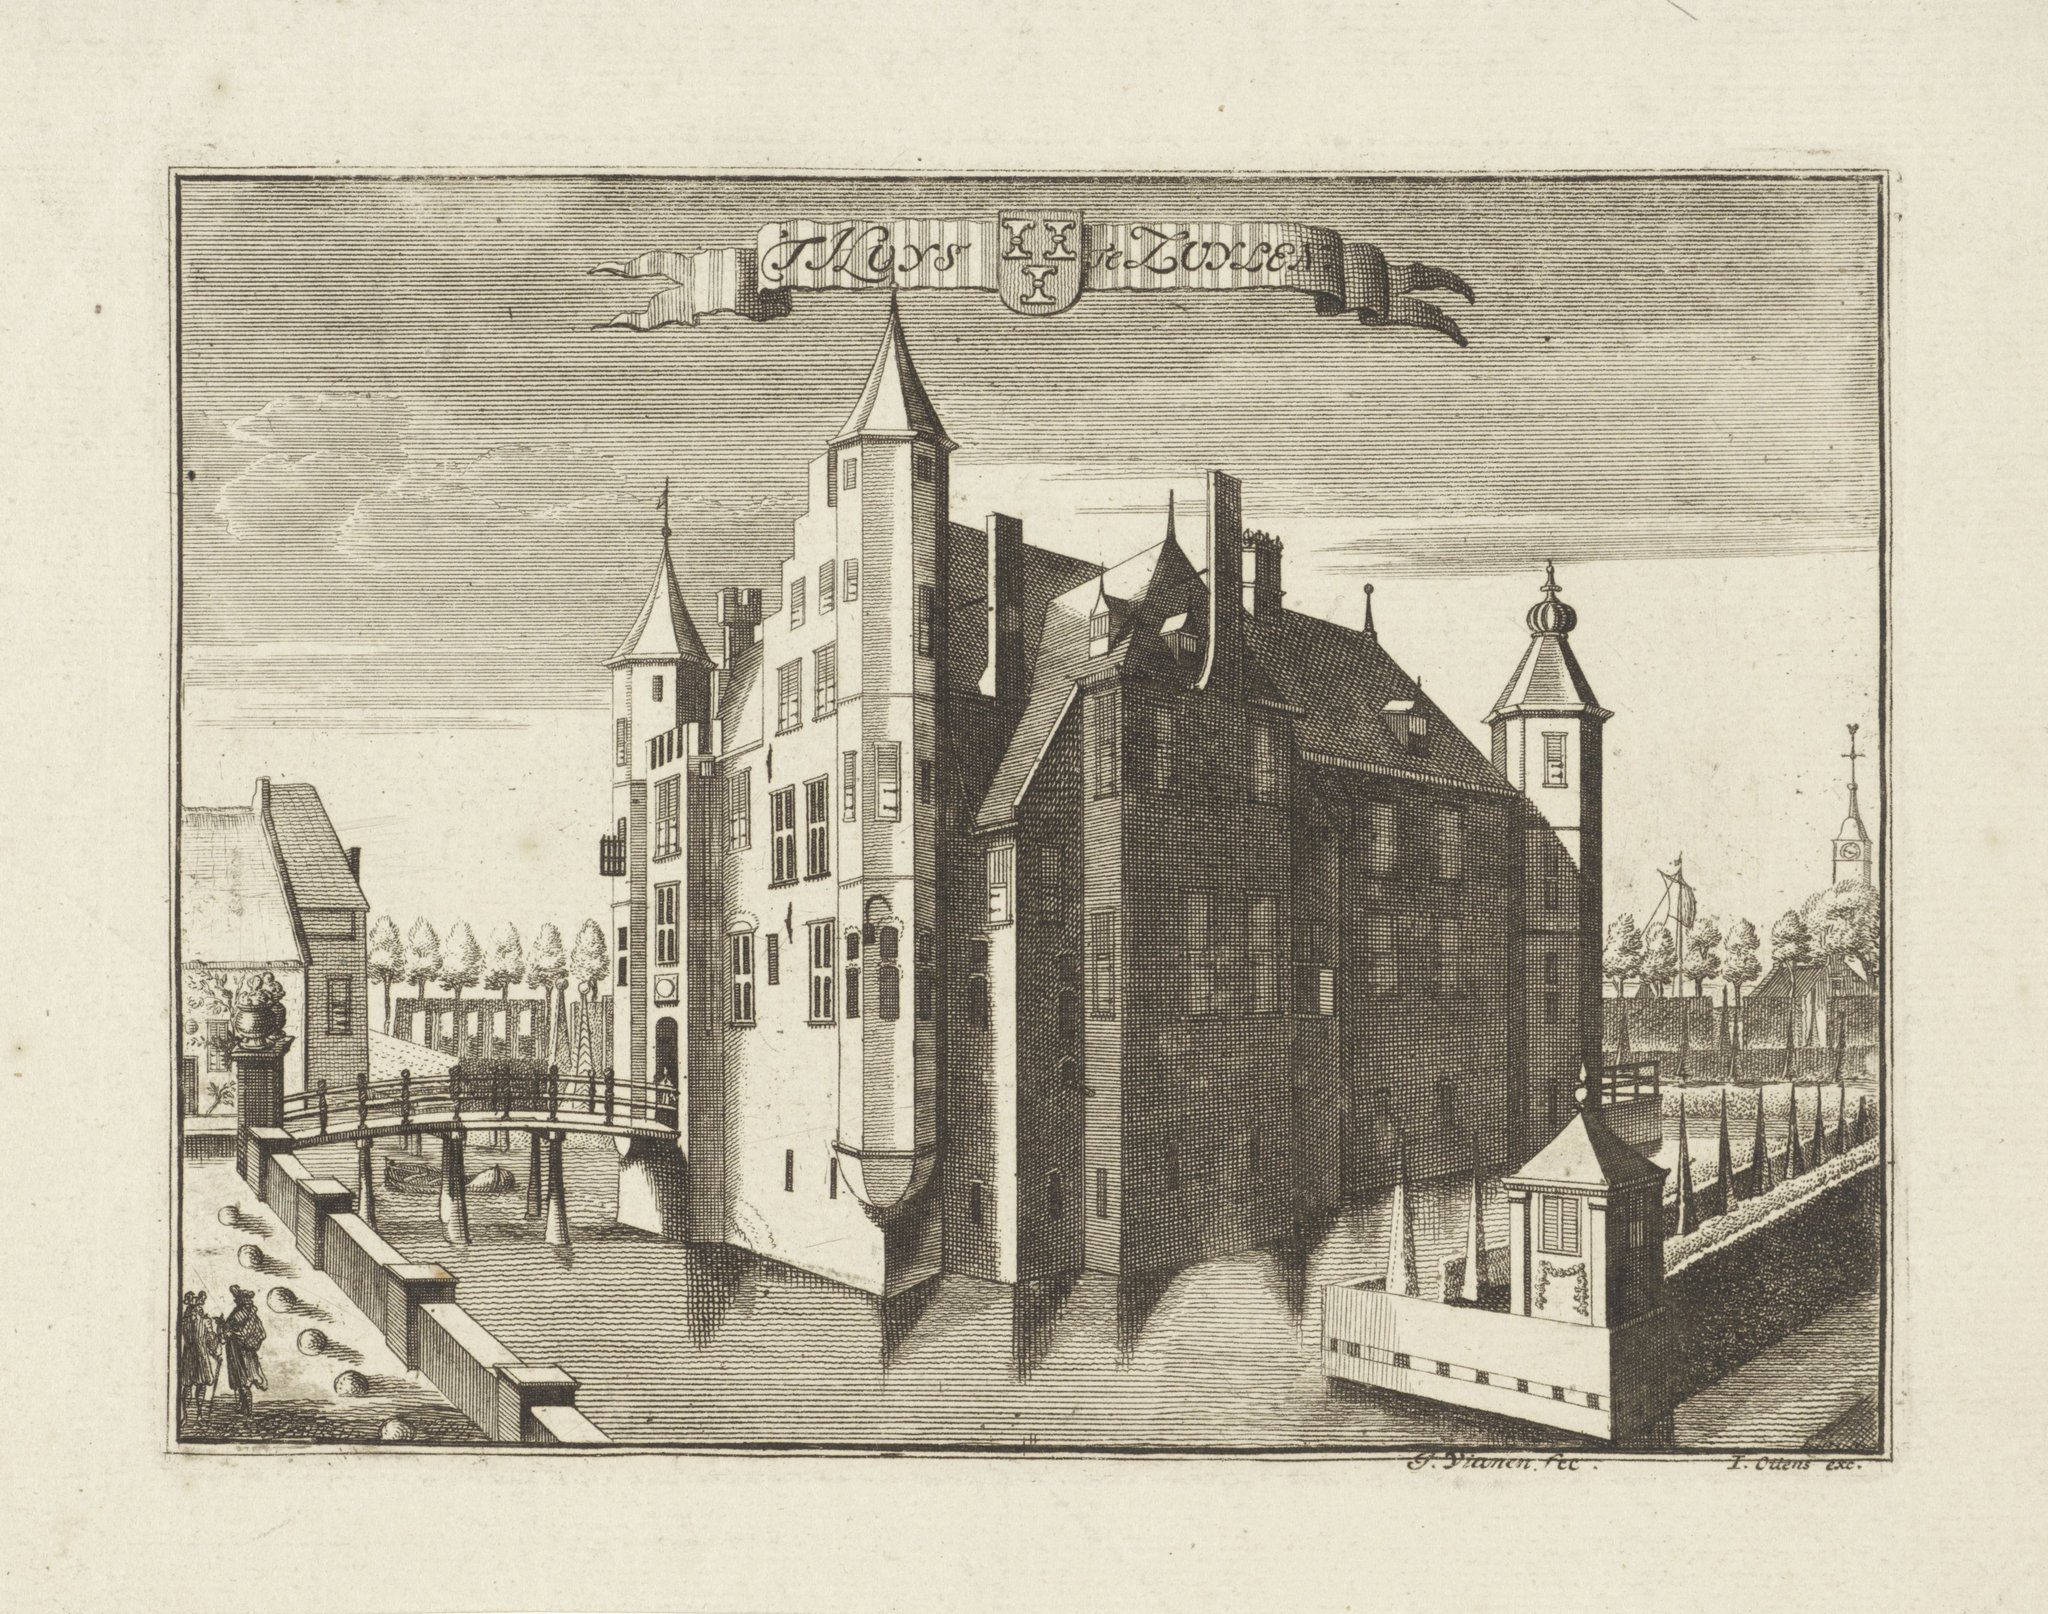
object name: print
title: 'T Huys Zuylen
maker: jan van vianen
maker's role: print maker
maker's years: 1660-1726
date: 1698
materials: paper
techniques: engraving, etching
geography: amsterdam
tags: castle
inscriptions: collector's mark: Lugt 2228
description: Eerste staat prent gebruikt in: Specht, Caspar. De ridder-matige huysen en gesighten jn de provincie van Utrecht. Utrecht: C. Specht, 1698. Tweede staat prent (volgens Hollstein) gebruikt als boekillustratie in: Specht, Caspar. Het verheerlykt Utrecht vertoont in de afbeeldingen der adelijke en riddermatige hofteden, in de heerlijkheid van Utrecht. Amsterdam: Reinier en Josua Ottens, s.a.